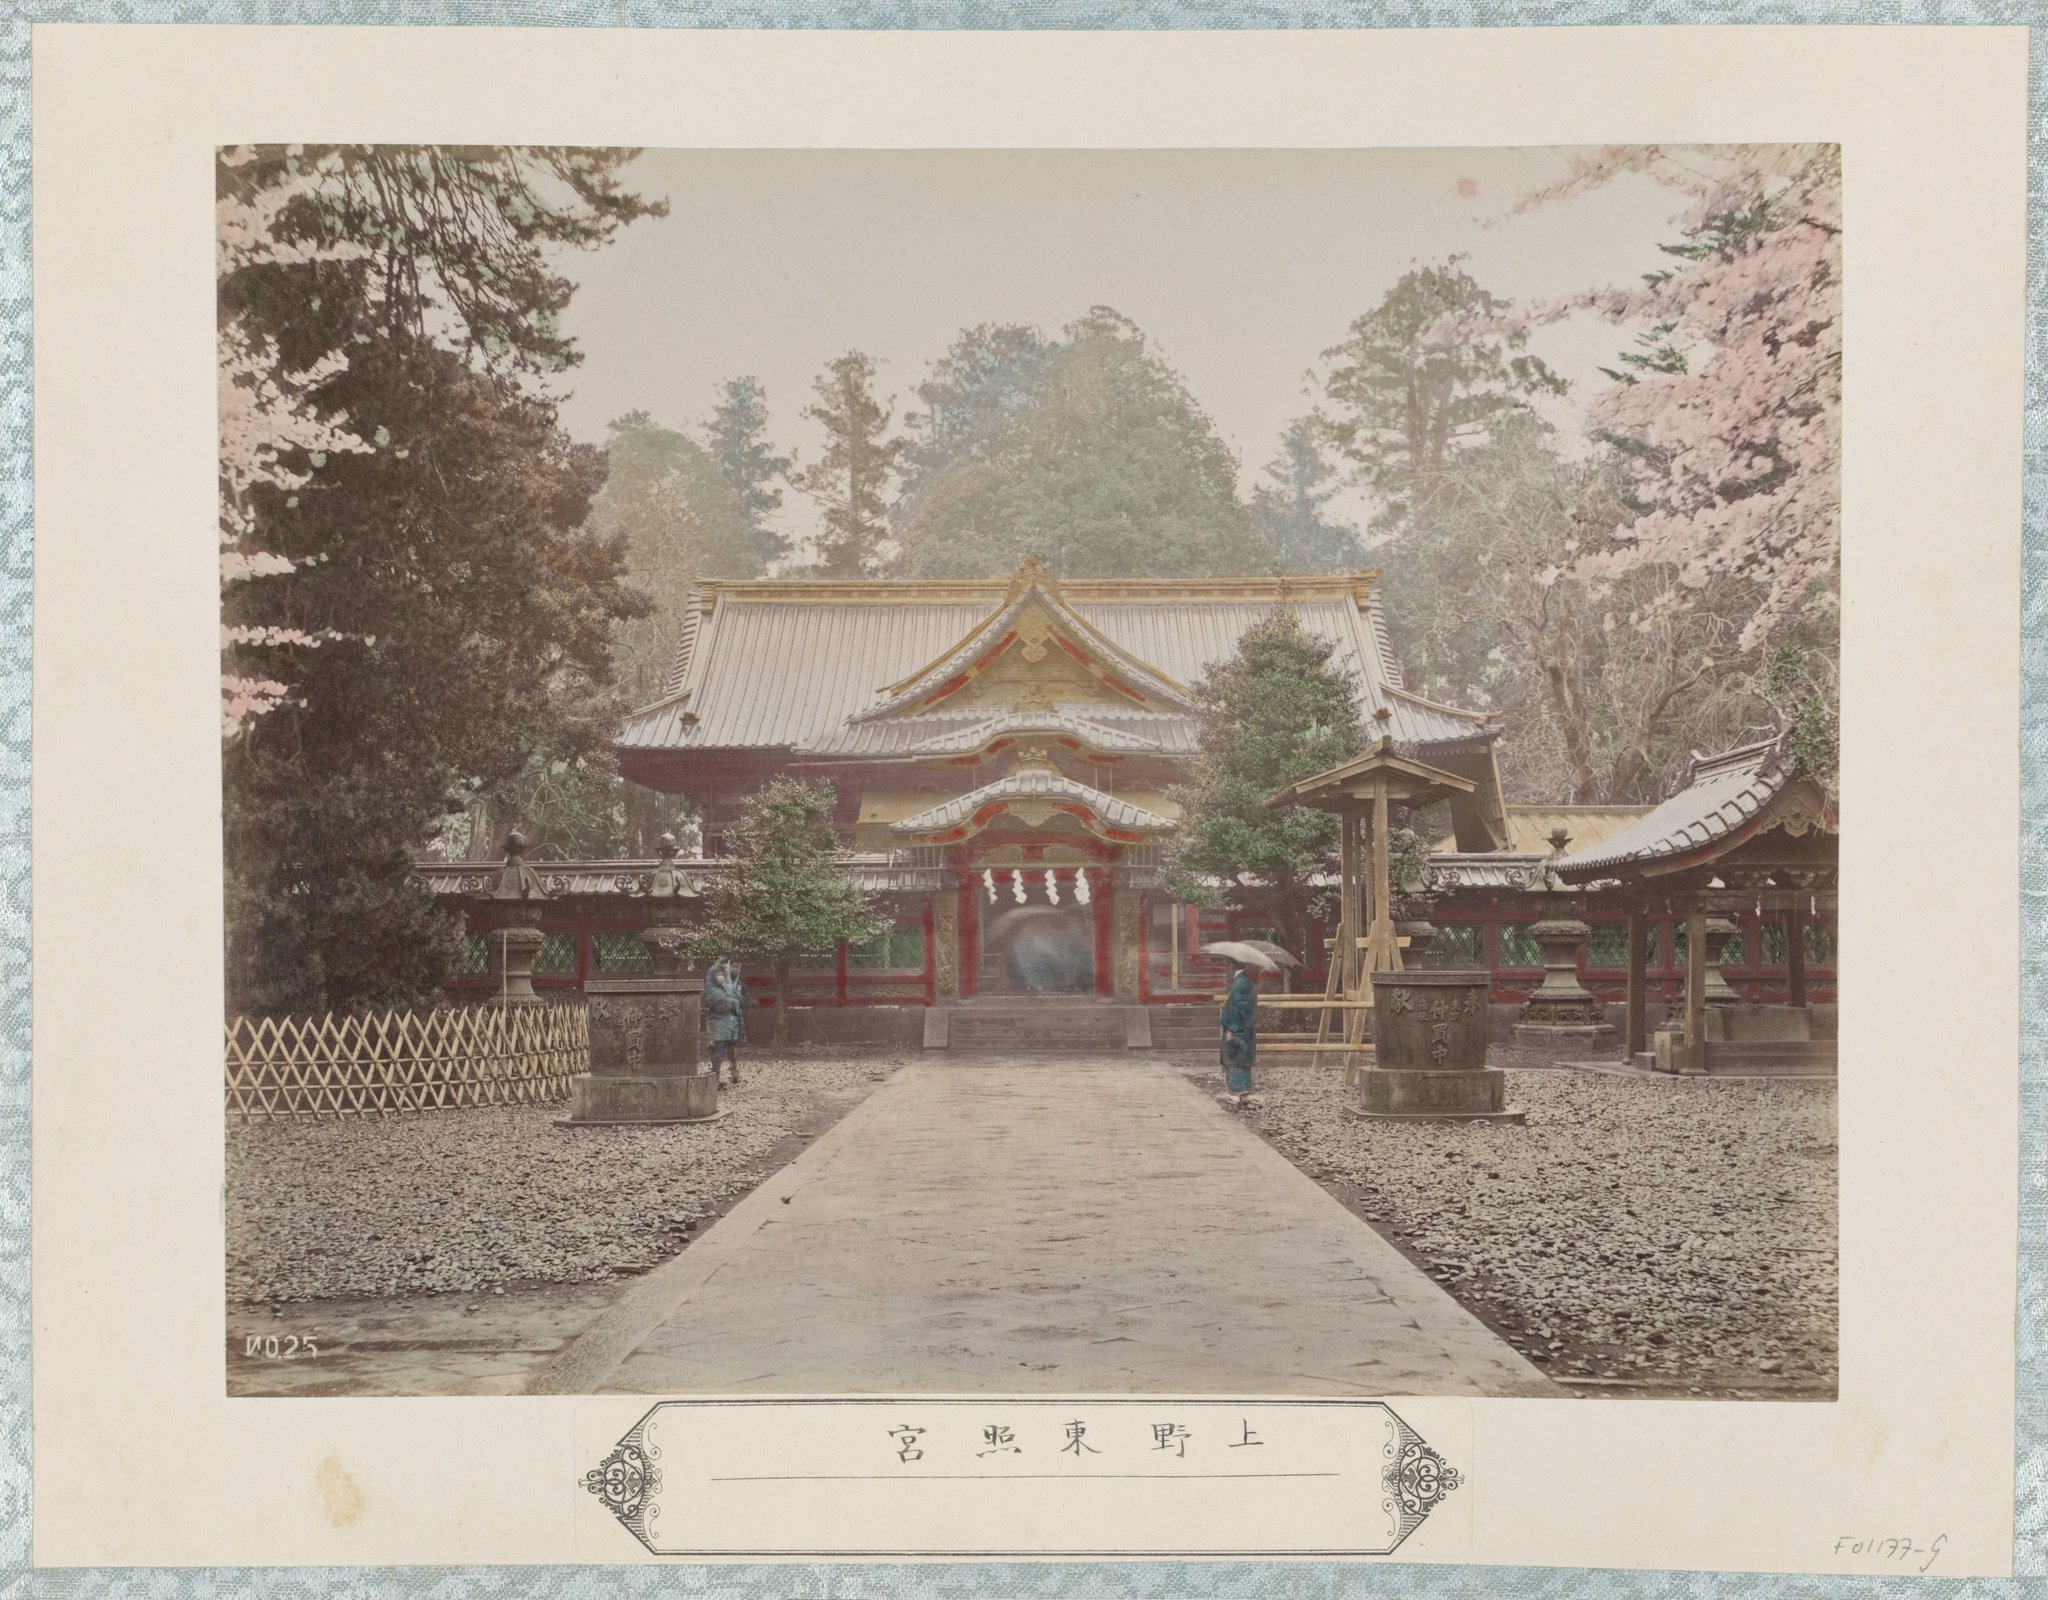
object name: photograph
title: Ueno Tôshôgû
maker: Anonymous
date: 1870-1900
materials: cardboard, paper, photographic support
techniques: albumen print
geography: tokyo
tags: temple, shrine ~ hinduism, buddhism, jainism, travelling; tourism, trees (+ flowers, blossom, blossoming)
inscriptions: negative number: ‘25’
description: Onderdeel van Leporelloalbum met 30 foto's van bezienswaardigheden in Japan.